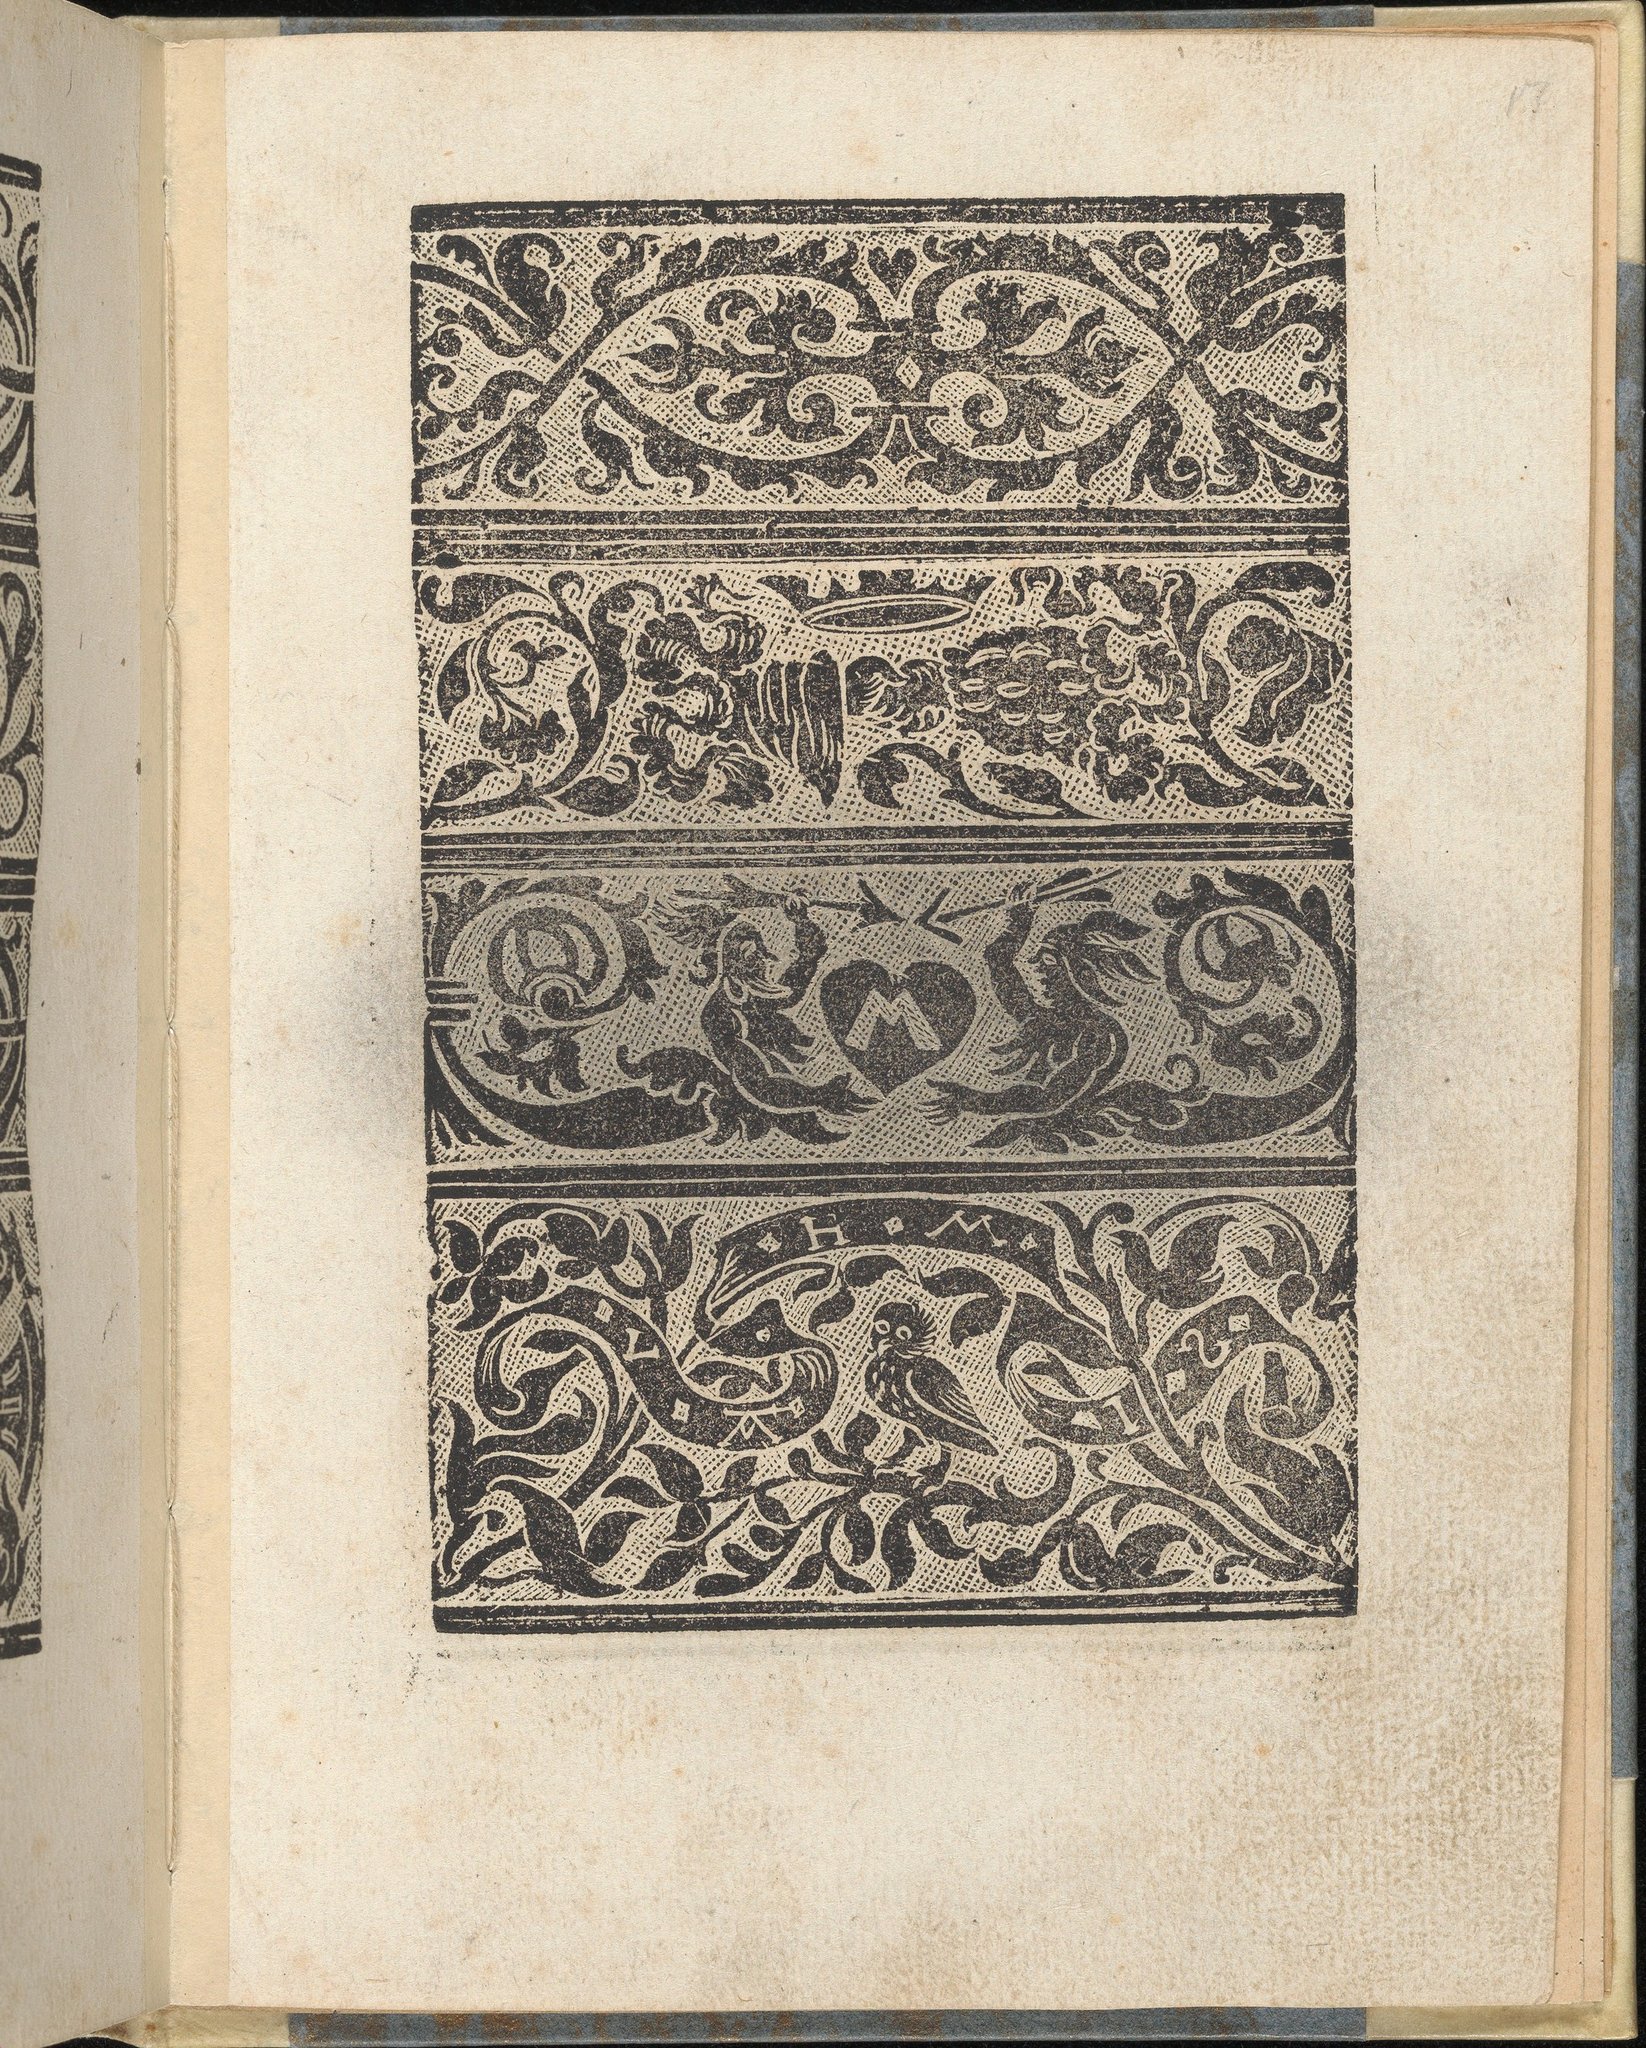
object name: book print ornament architecture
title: Ein ney Furmbüchlein, Page 17, recto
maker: johann schönsperger the younger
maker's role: publisher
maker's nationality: german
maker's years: 1490-1550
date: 1525-1529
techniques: woodcut